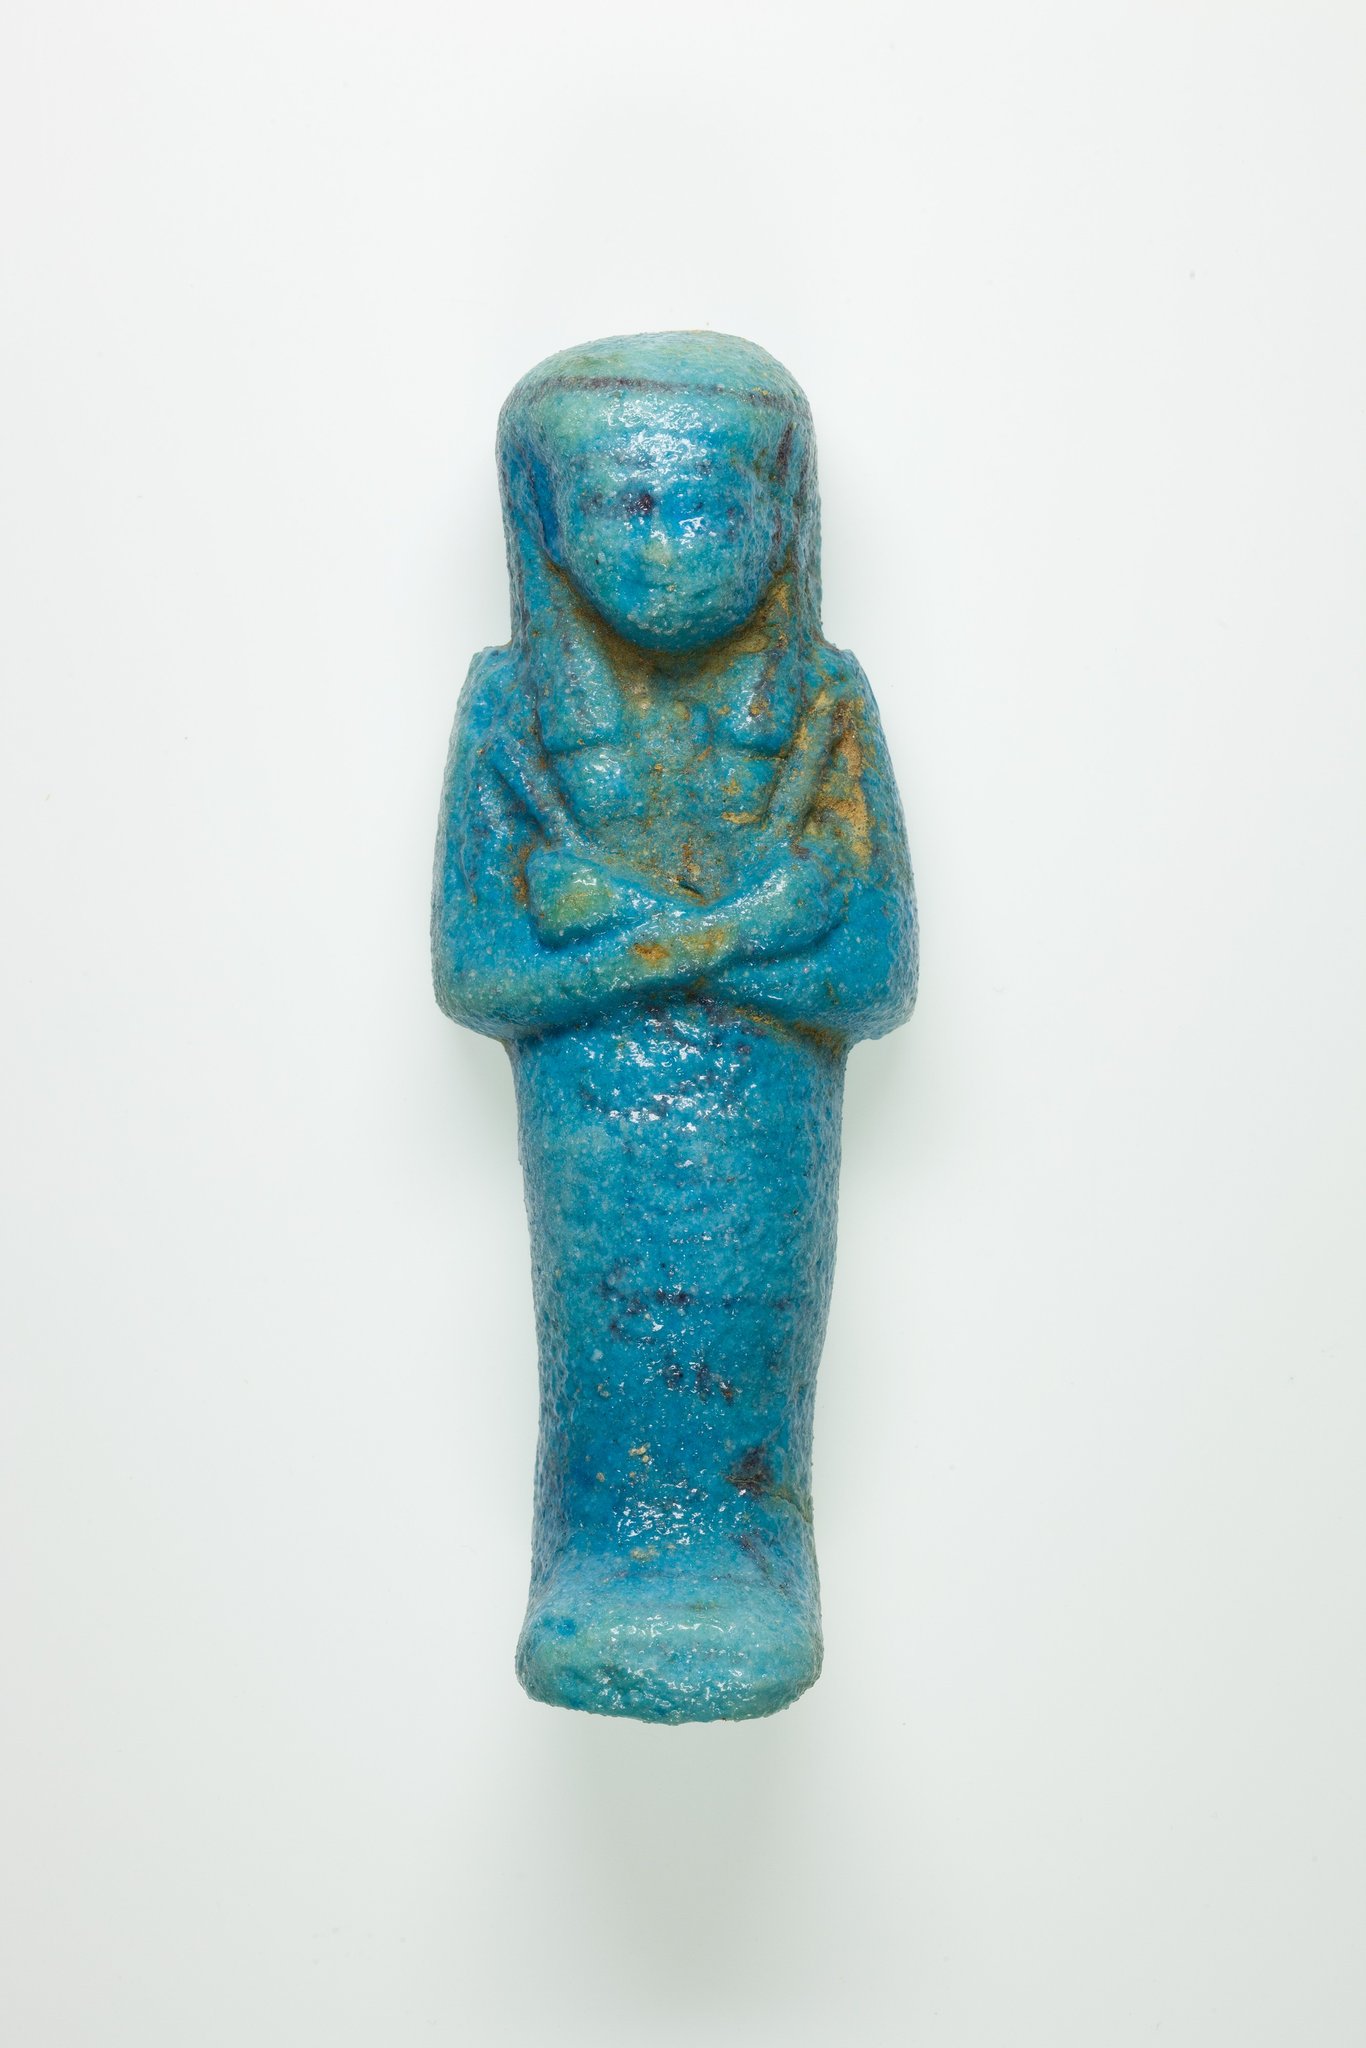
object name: worker shabti, henettawy c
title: Worker Shabti of Henettawy (C), Daughter of Isetemkheb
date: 990-970 BCE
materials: faience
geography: egypt